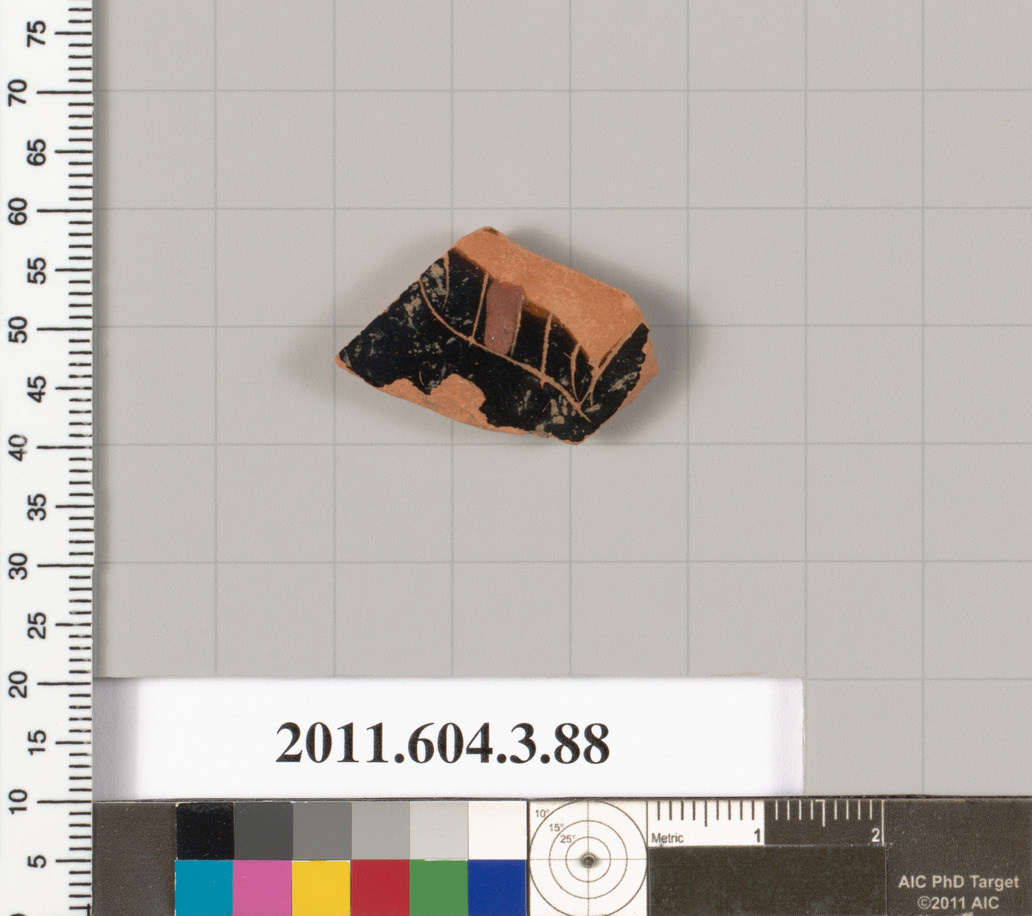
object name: amphora fragment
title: Terracotta fragment of an amphora (jar)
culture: greek, attic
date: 525-501 BCE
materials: terracotta